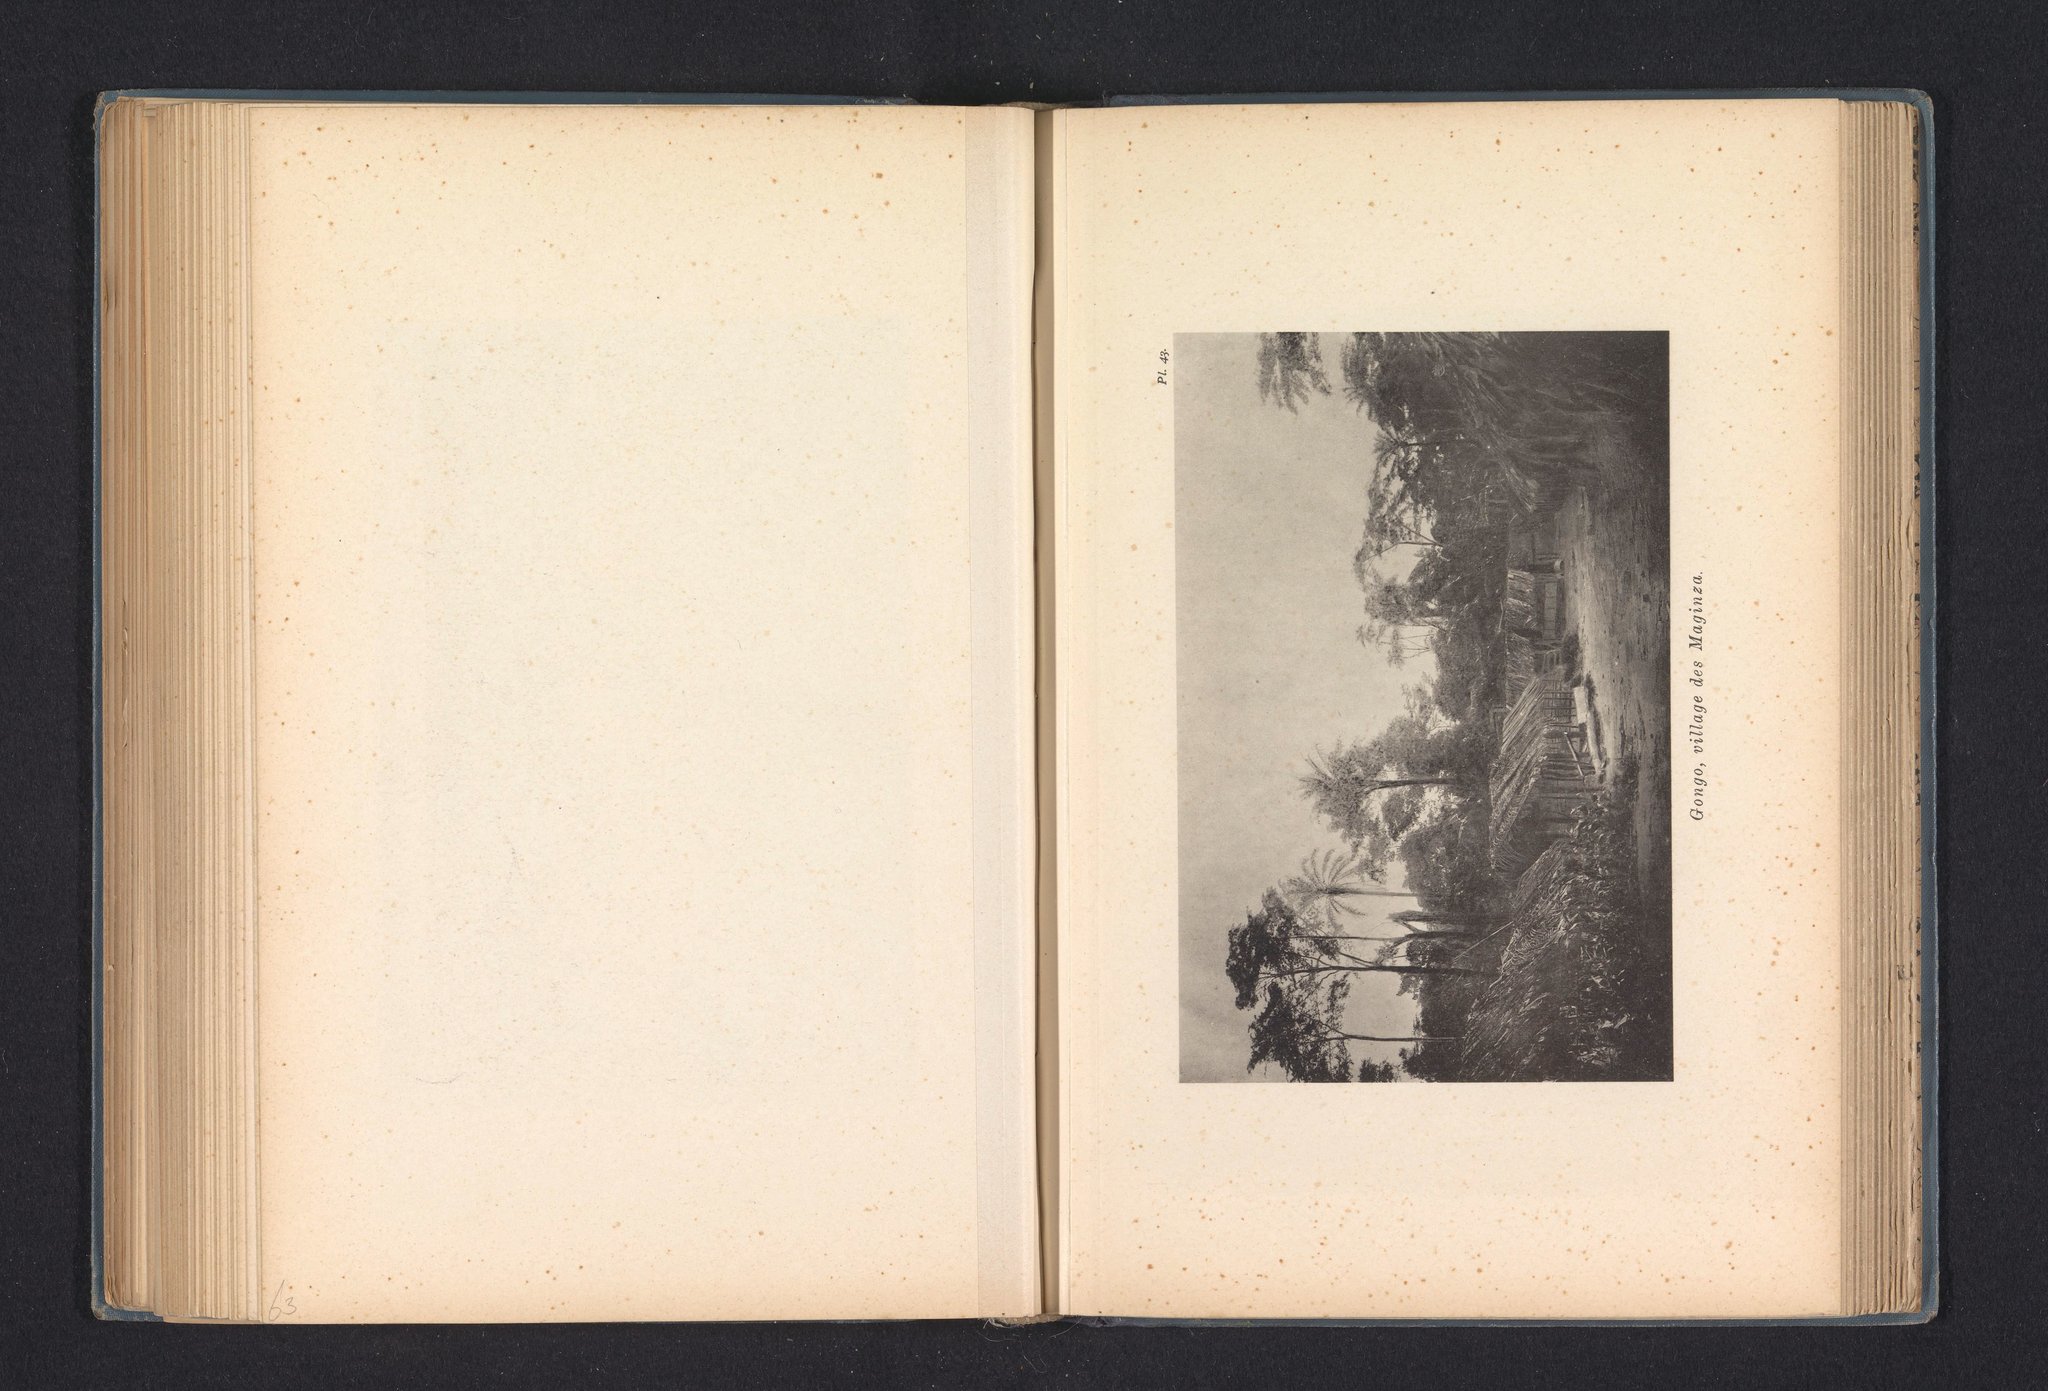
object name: photomechanical print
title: Gongo, village des Maginza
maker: franz thonner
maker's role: botanicus, ontdekkingsreiziger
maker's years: 1863-1928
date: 1896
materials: paper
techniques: photograph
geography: dresden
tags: housing, façade (of house or building)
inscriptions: number: ‘Pl. 43.’